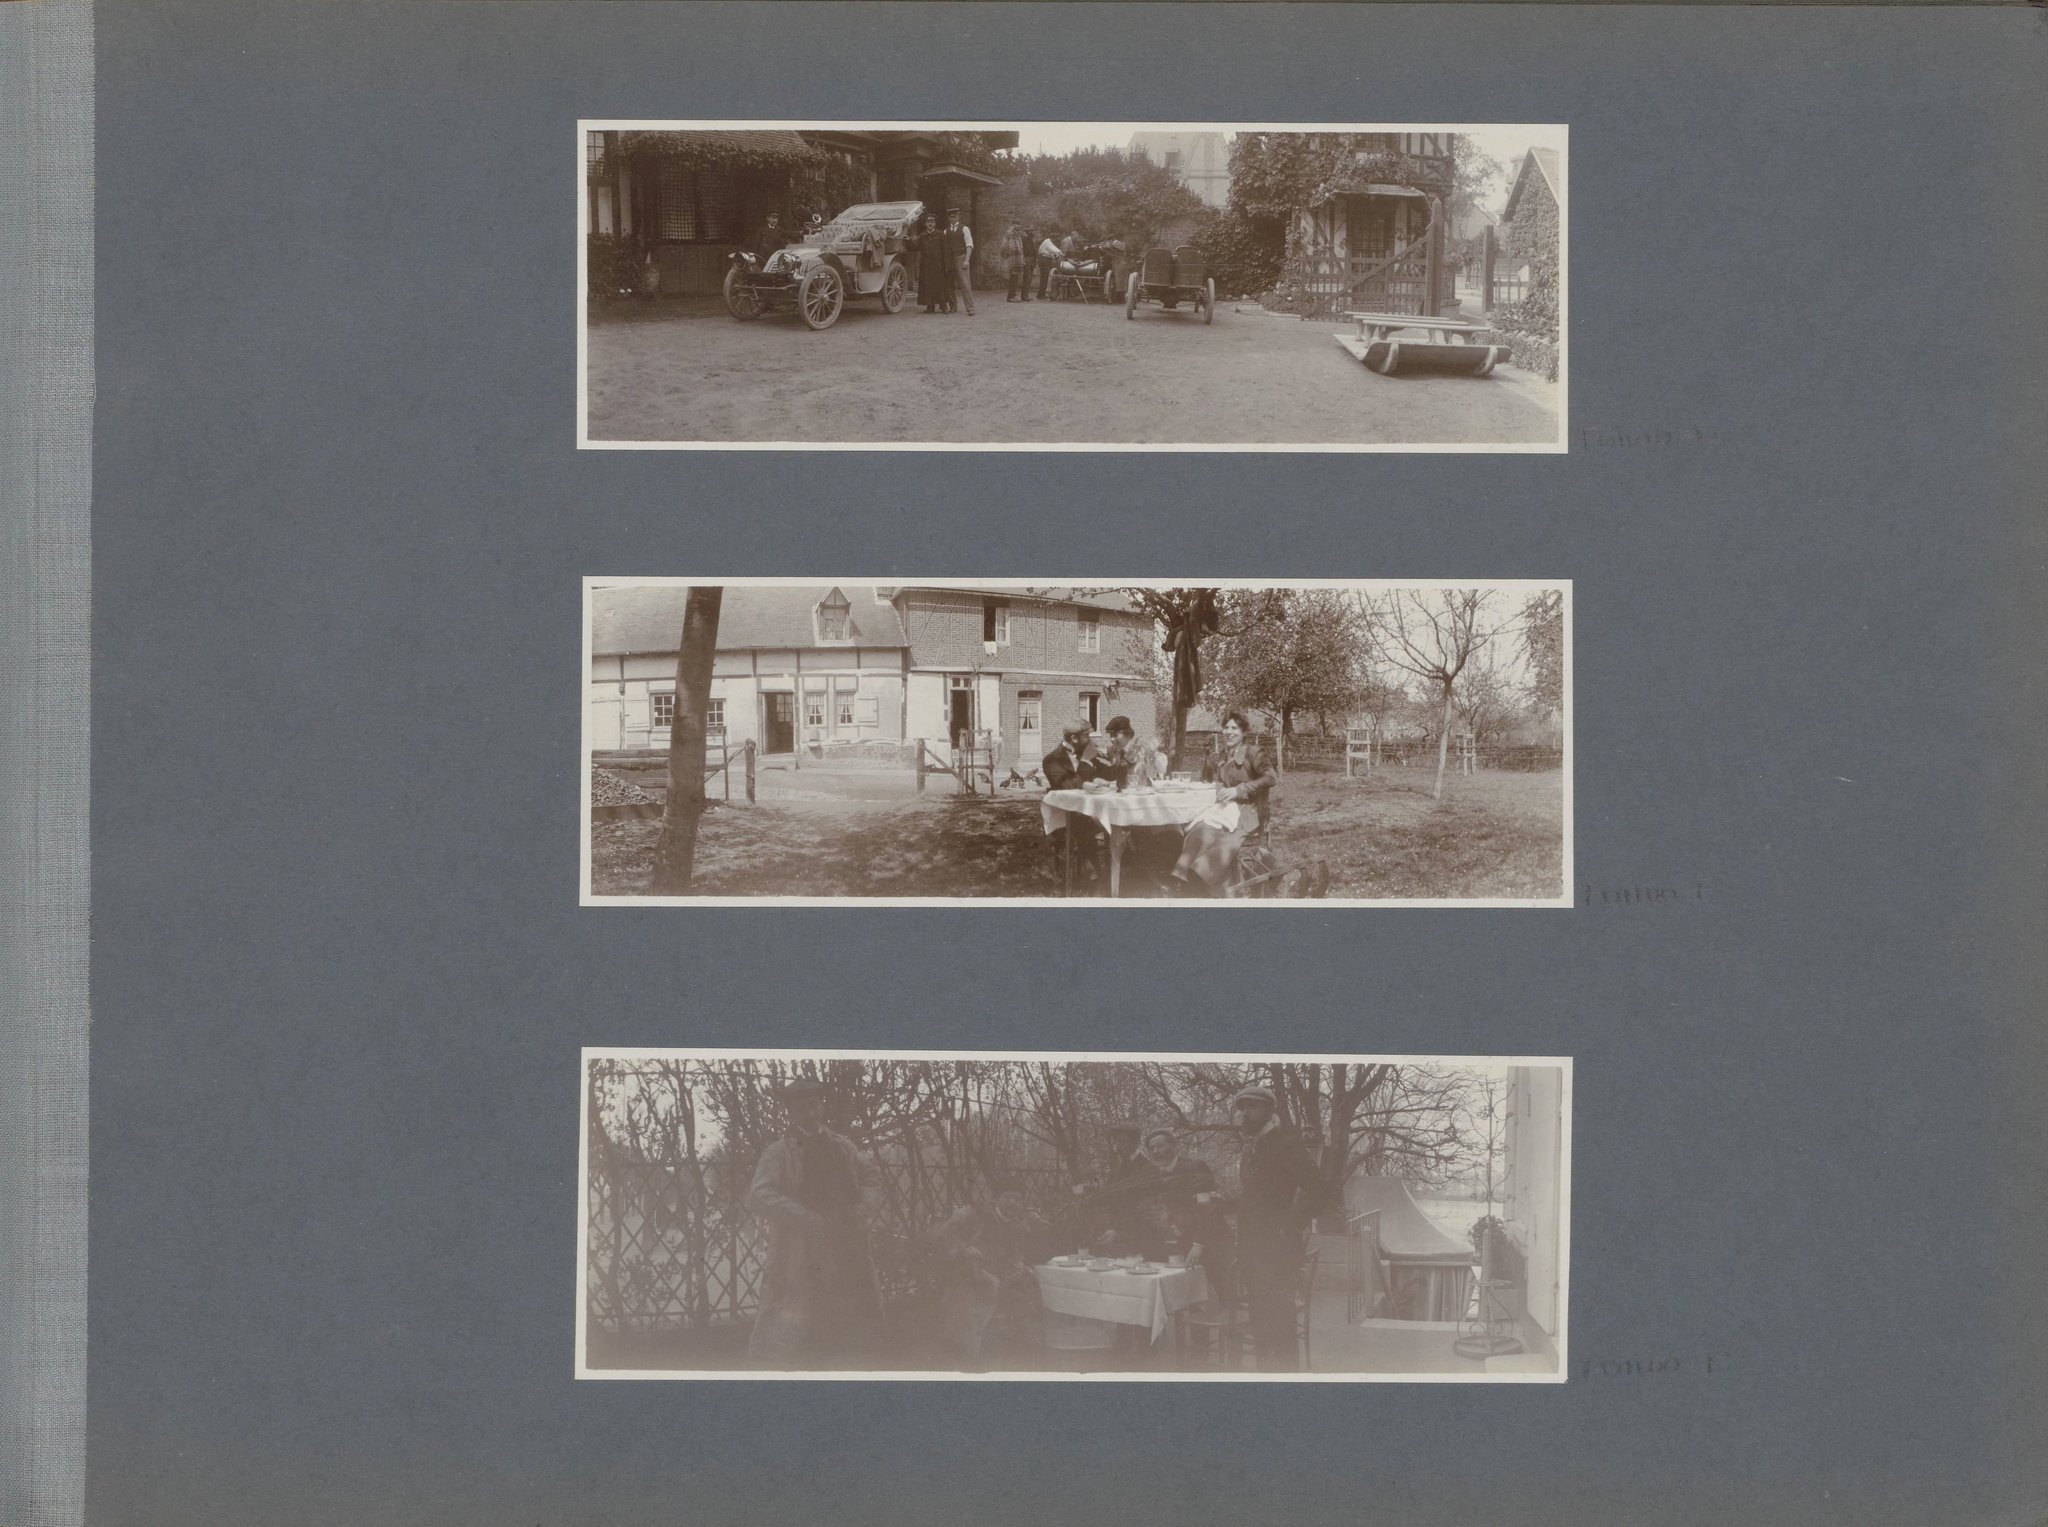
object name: photograph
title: Picknick in een boomgaard in Frankrijk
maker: Anonymous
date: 1902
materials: paper, photographic support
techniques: daylight paper print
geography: france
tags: eating and drinking, orchard, france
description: Onderdeel van Fotoalbum van een legeroefening in Zuidwest-Frankrijk in 1902.